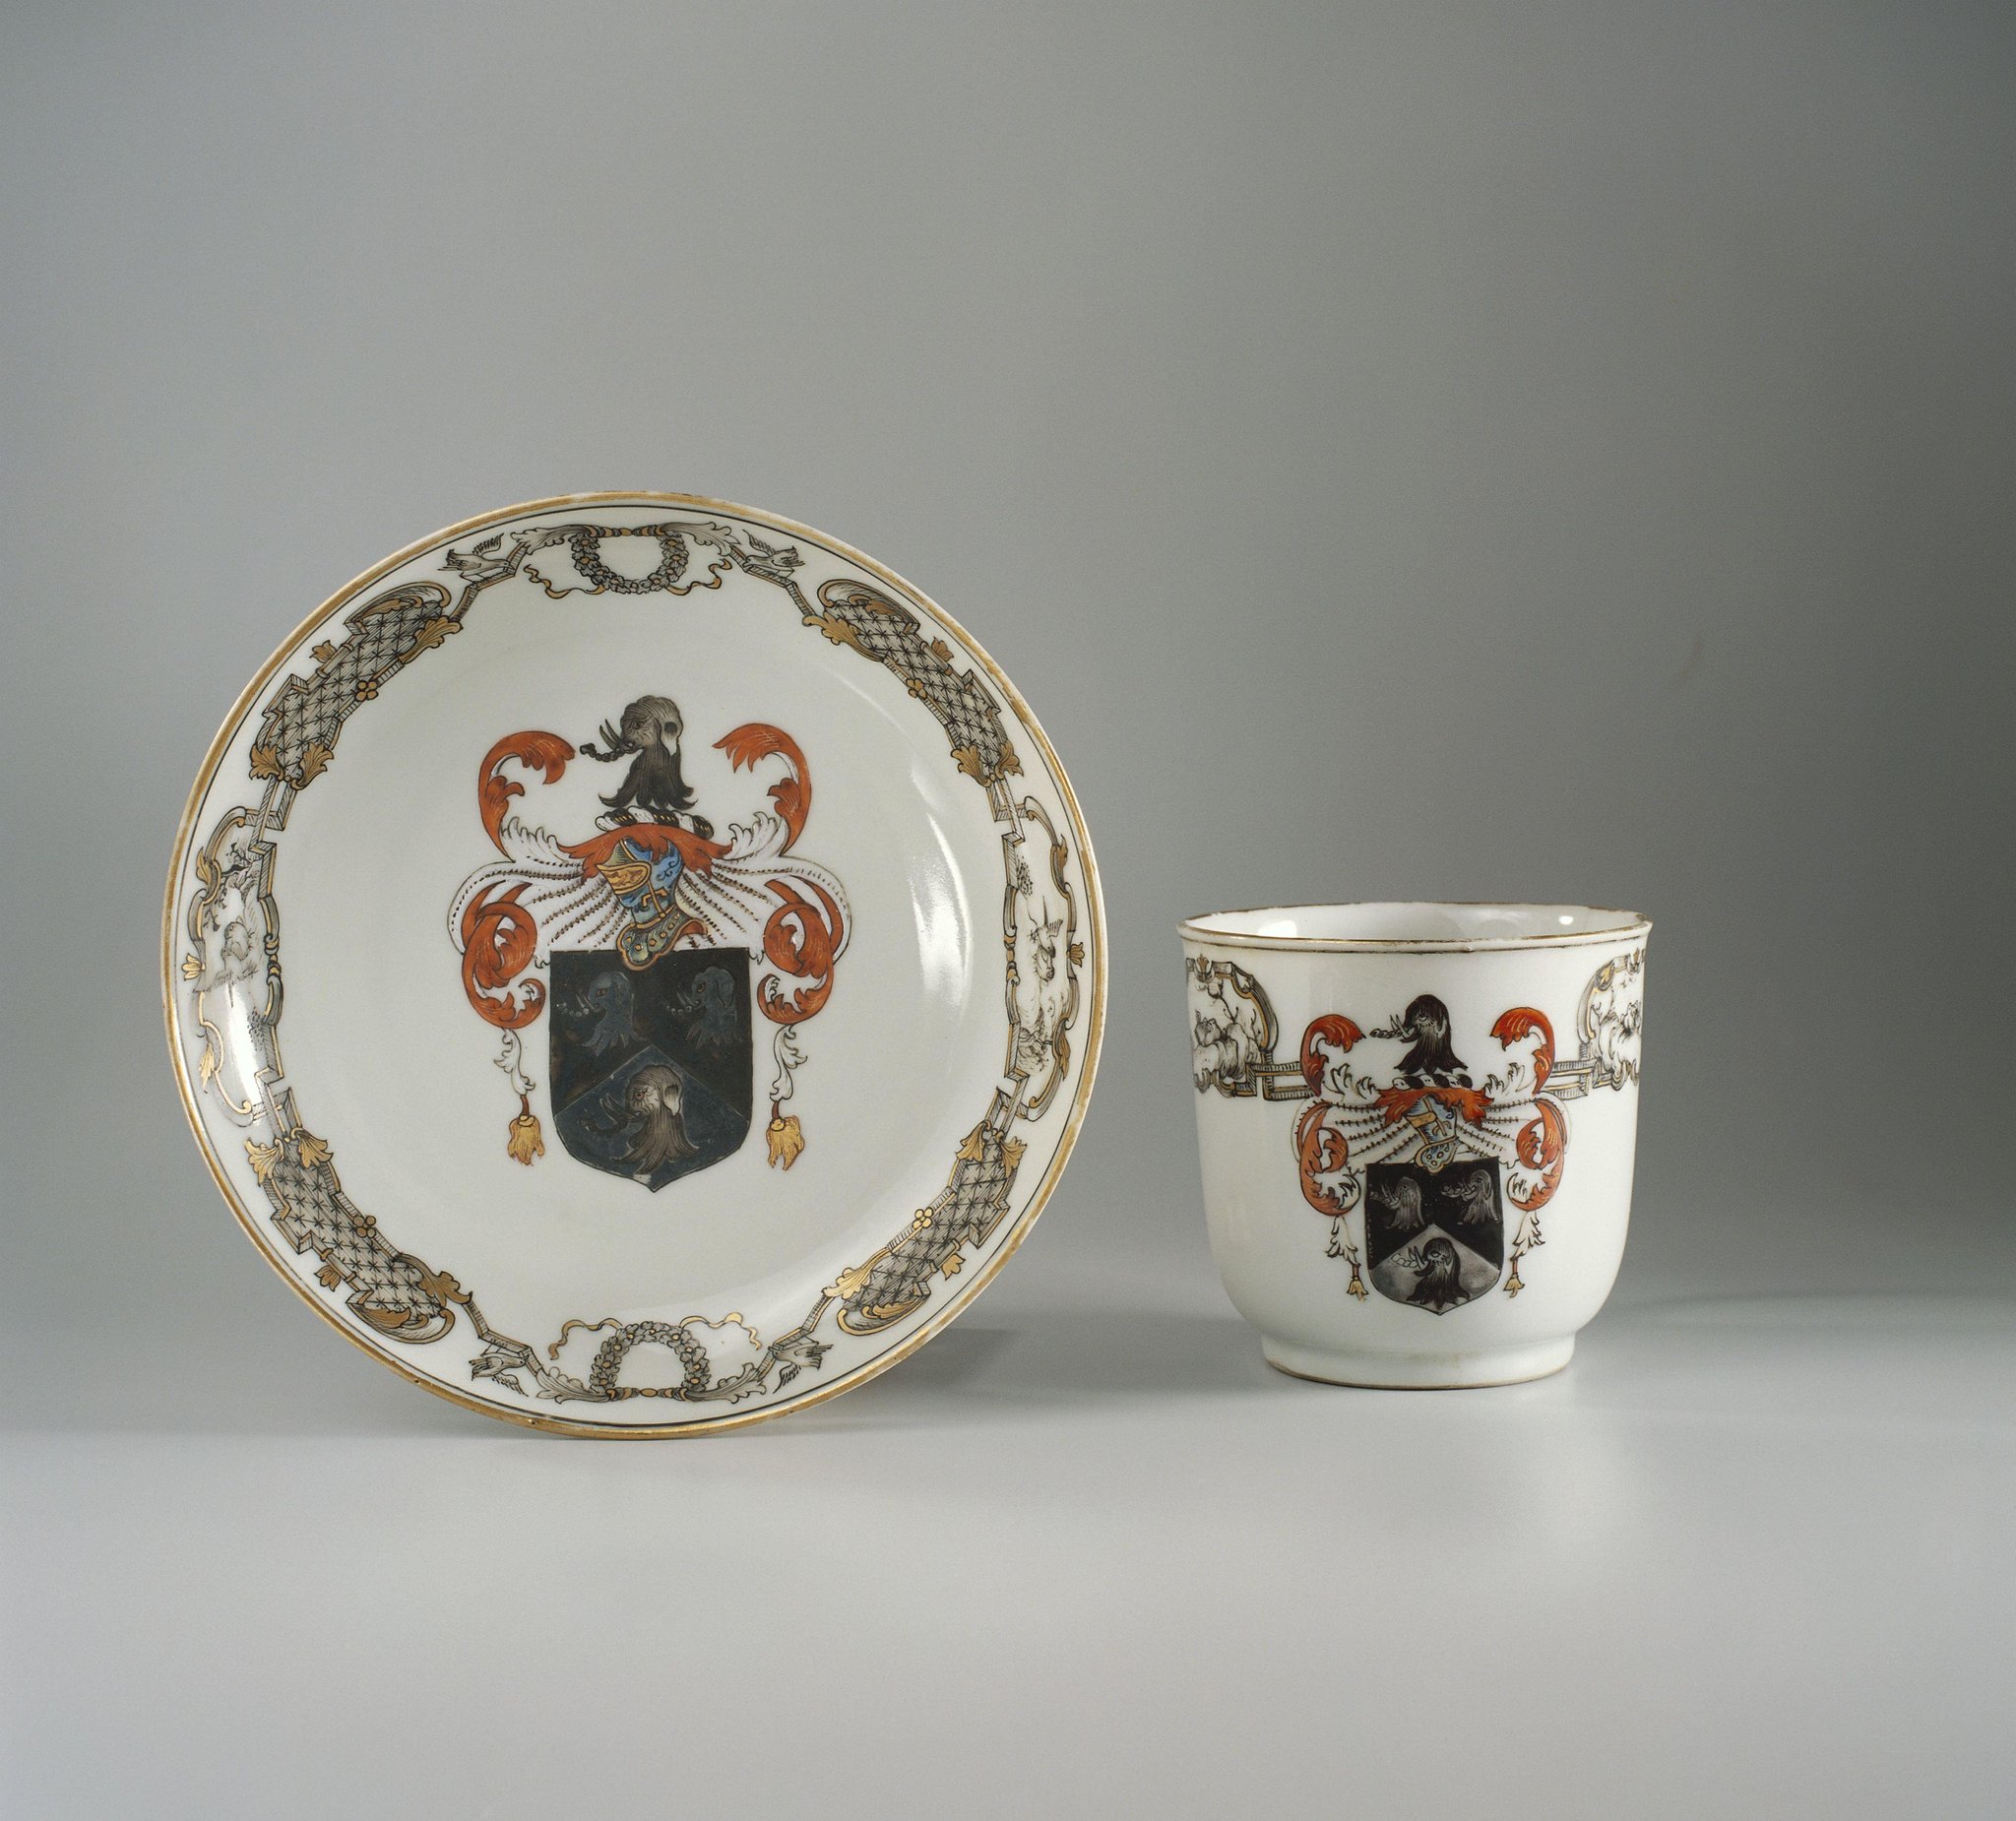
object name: kop en schotel, kop en schotel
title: Saucer with the arms of the Saunders family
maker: Anonymous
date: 1725-1749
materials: glaze, gold, paint, porcelain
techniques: firing, gilding, turning, vitrification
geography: china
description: Schotel van porselein, beschilderd op het glazuur in blauw, rood, zwart en goud. Op het plat van de schotel het wapen van de familie Saunders met drie olifanten; het helmteken is tevens een olifant omgeven door acanthusbladeren. Op de wand een Europese decoratieve band in Lodewijk XIV-stijl met vogels en servetwerk in cartouches. Oud label op de onderzijde met 'Saunders (governor of Madras)'. Wapenporselein met emailkleuren.